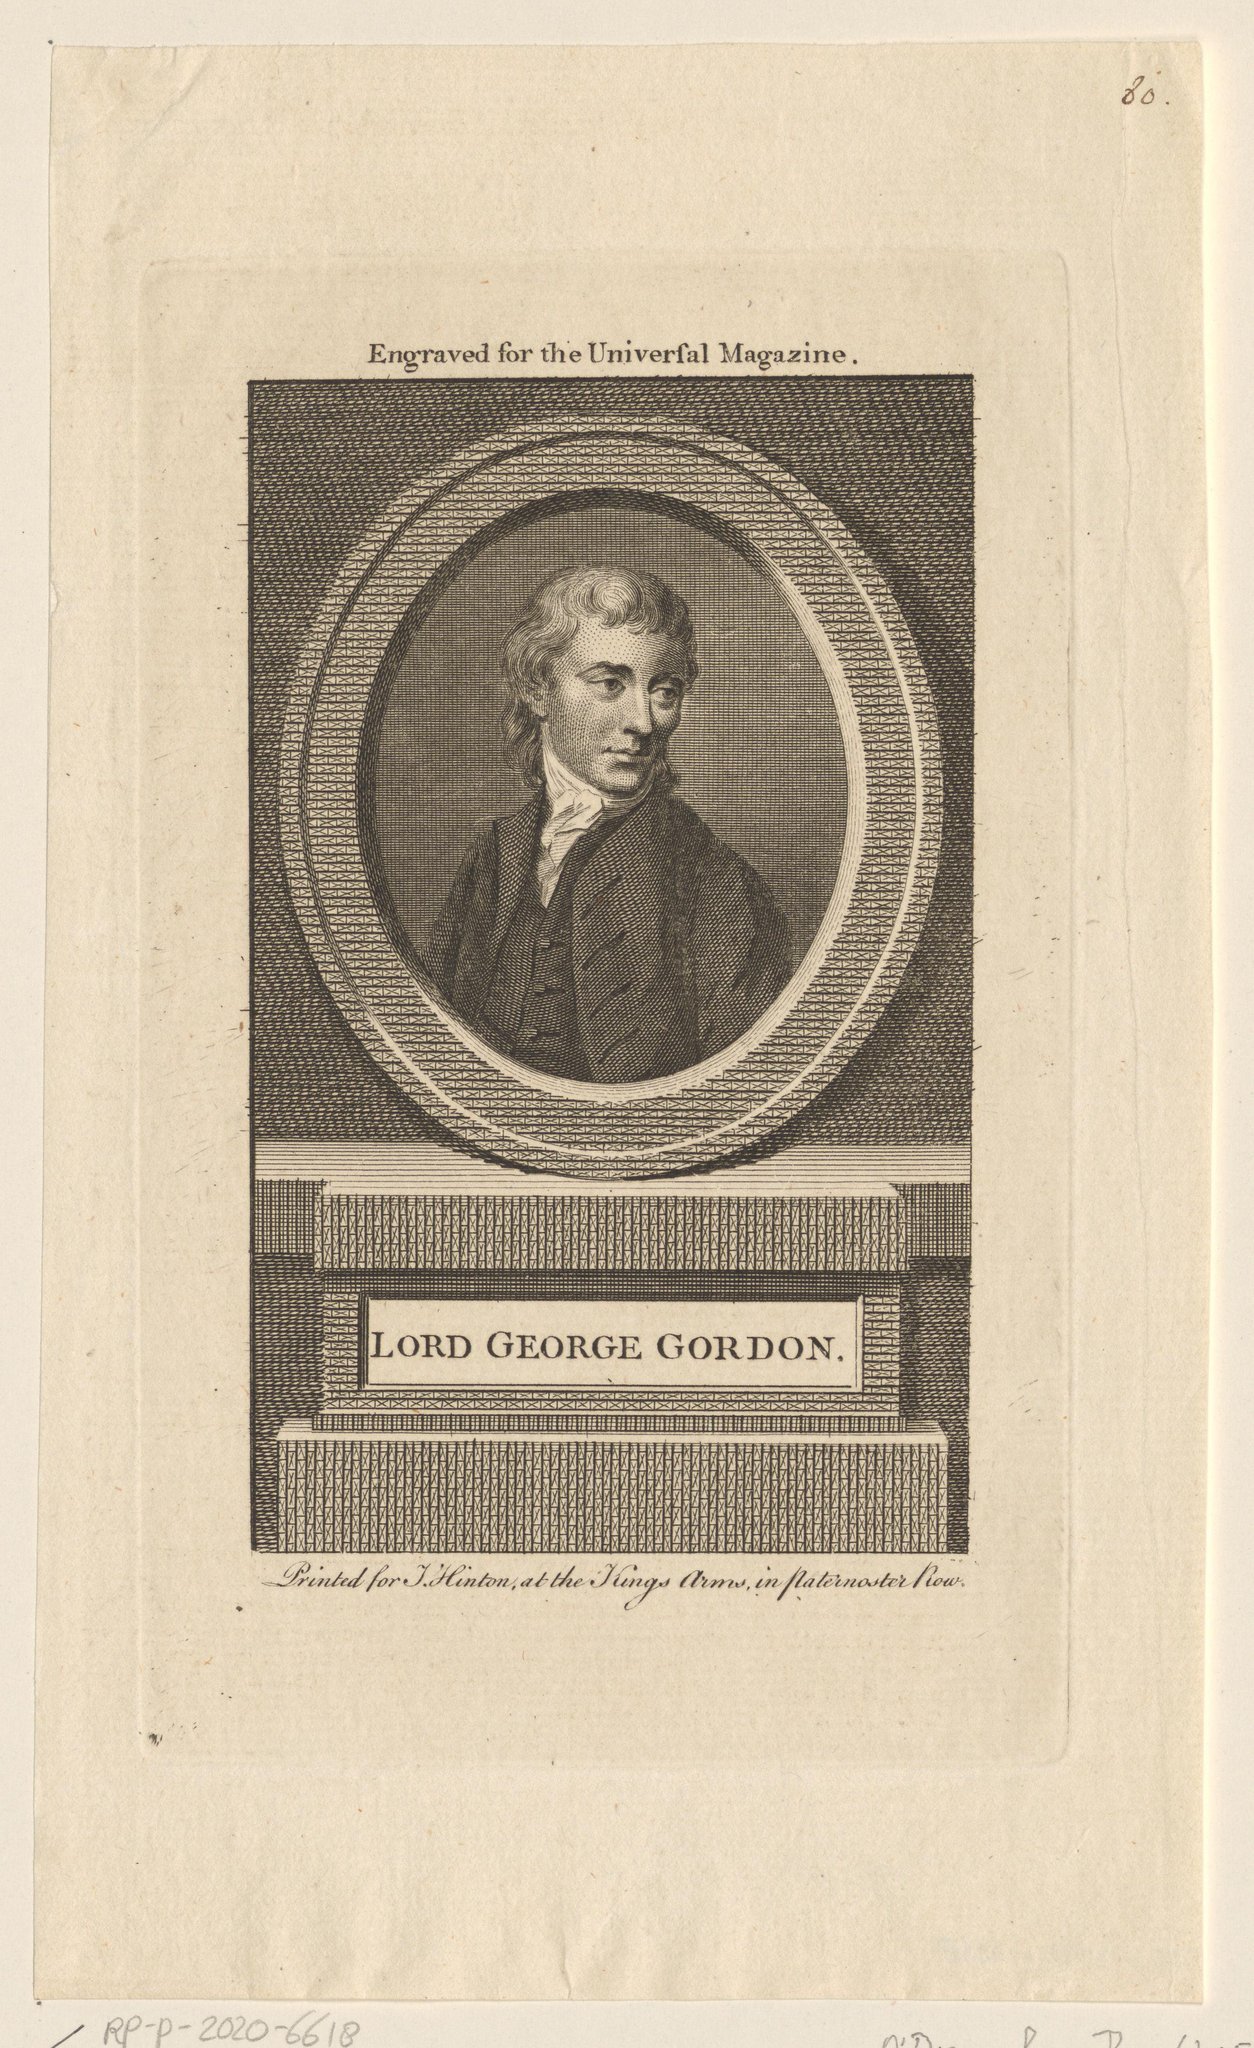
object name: print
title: Portret van George Gordon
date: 1747-1781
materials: paper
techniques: engraving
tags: historical persons, politician, e.g. party leader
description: Prent uit: The Universal Magazine of Knowledge and Pleasure, 1747-1781.